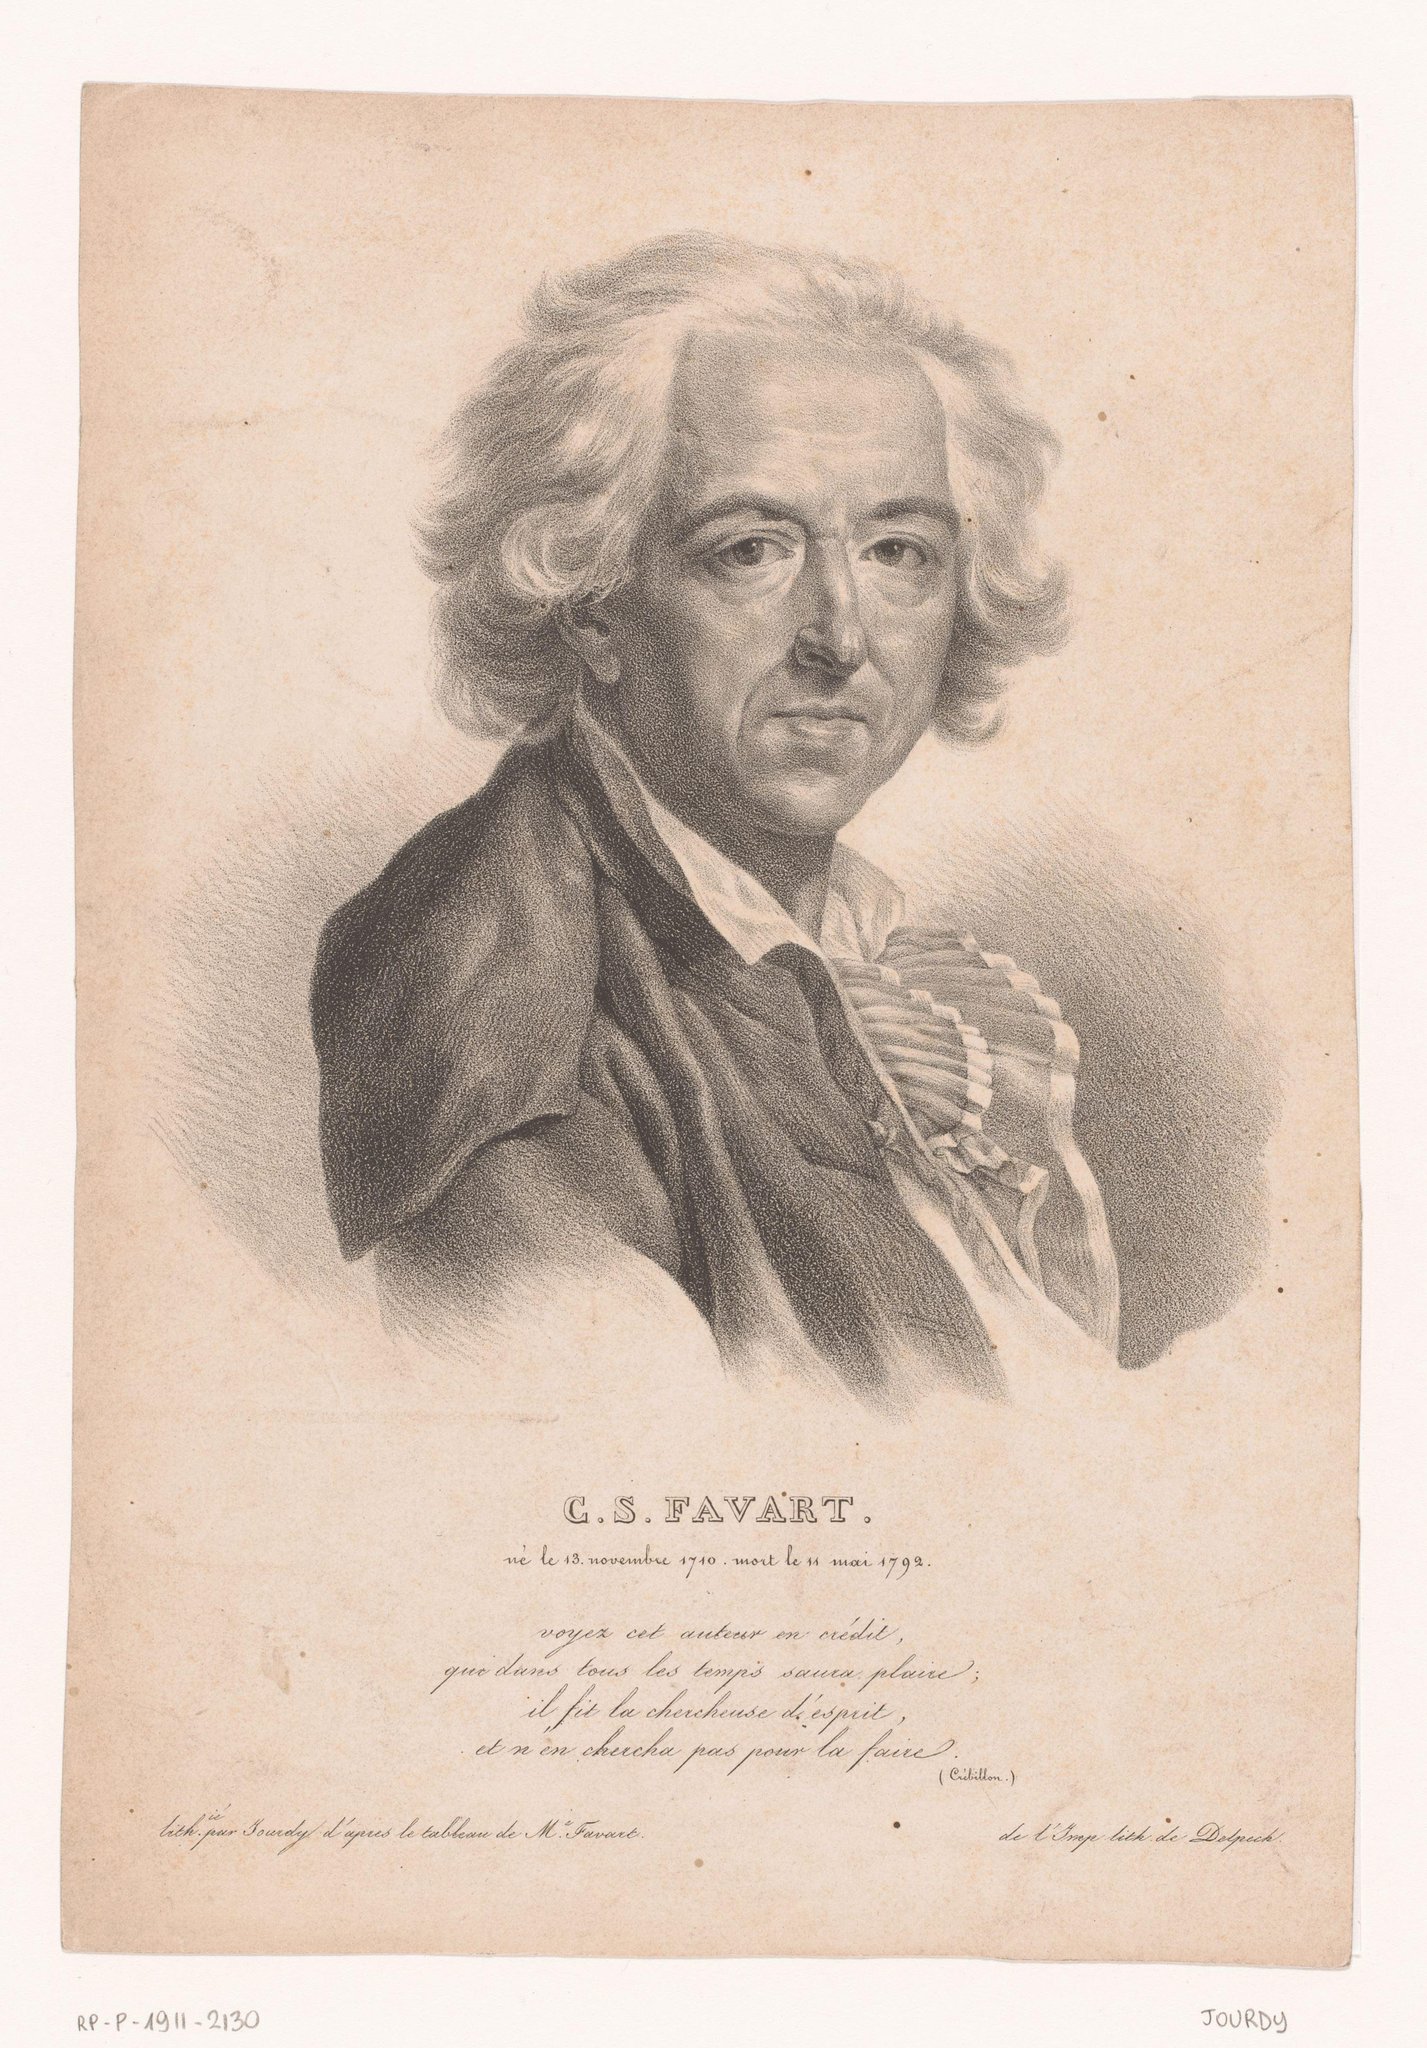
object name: print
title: Portret van Charles-Simon Favart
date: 1830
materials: paper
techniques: lithograph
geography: paris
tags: charles simon favart, historical persons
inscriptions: collector's mark: Lugt 2228a